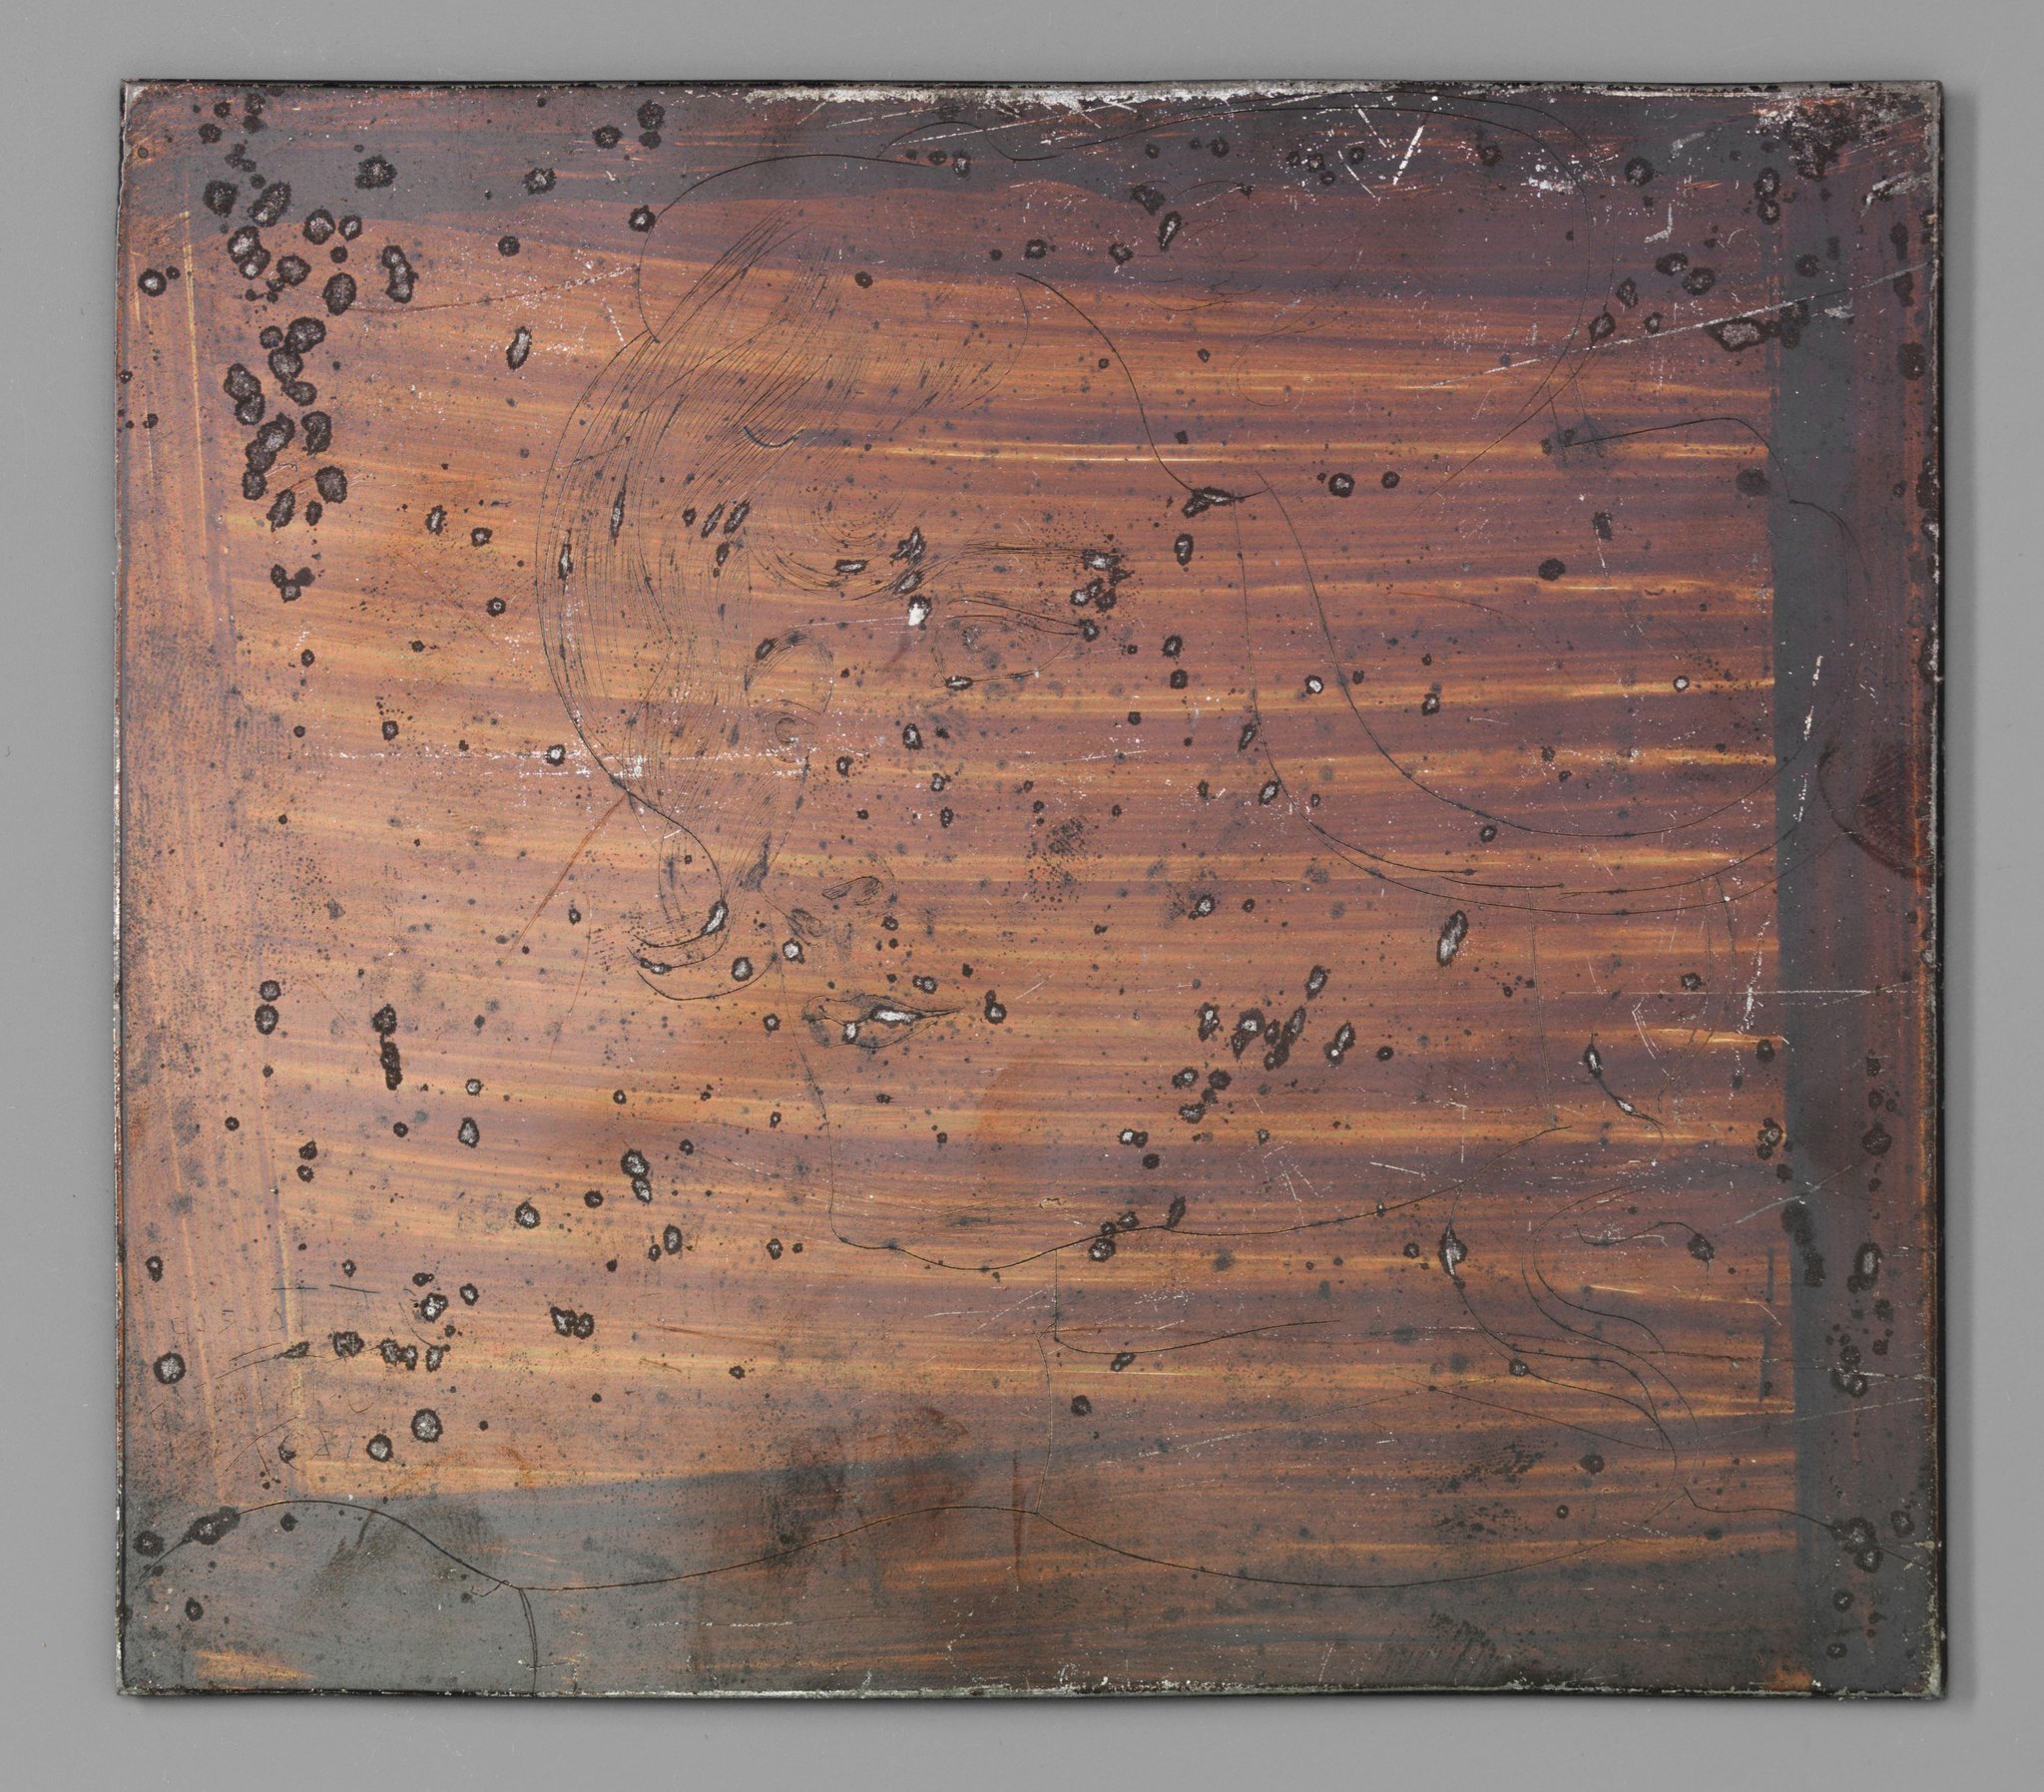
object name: zinkplaat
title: Portret van Marguérite Helfrich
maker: jan toorop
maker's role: draughtsman, painter, print maker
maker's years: 1858-1928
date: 1897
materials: zinc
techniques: drypoint